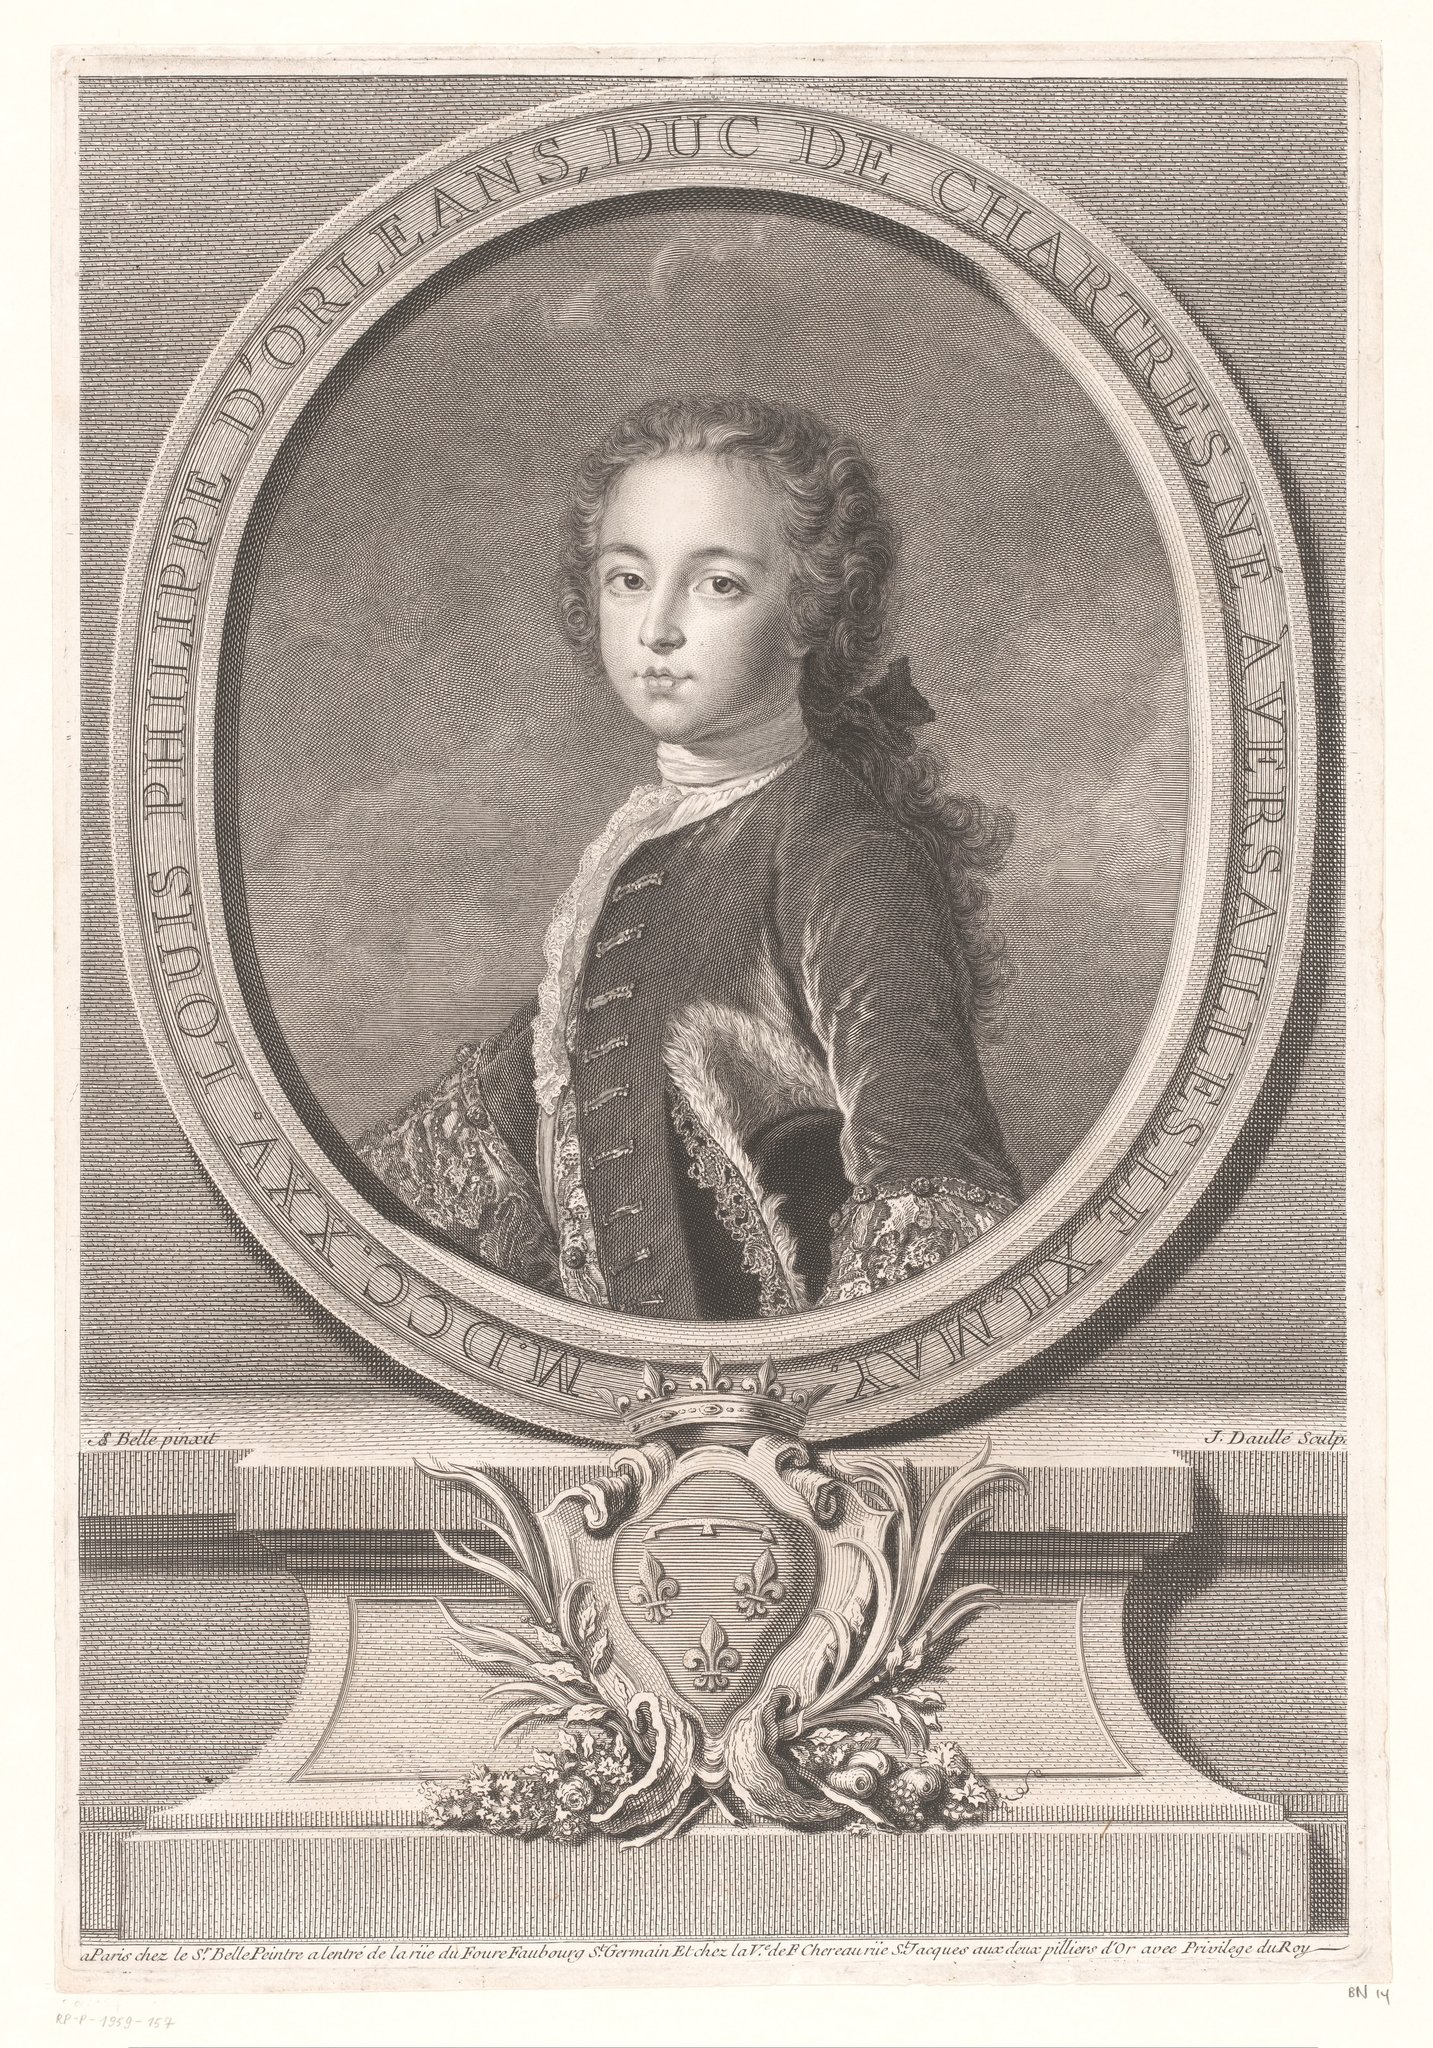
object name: print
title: Portret van Lodewijk Filips I van Orléans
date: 1731-1763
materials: paper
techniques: etching, engraving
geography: france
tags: lodewijk filips i van orléans, ornament ~ medallion, historical persons, armorial bearing, heraldry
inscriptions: collector's mark: Lugt 2228, collector's mark: Lugt 2760